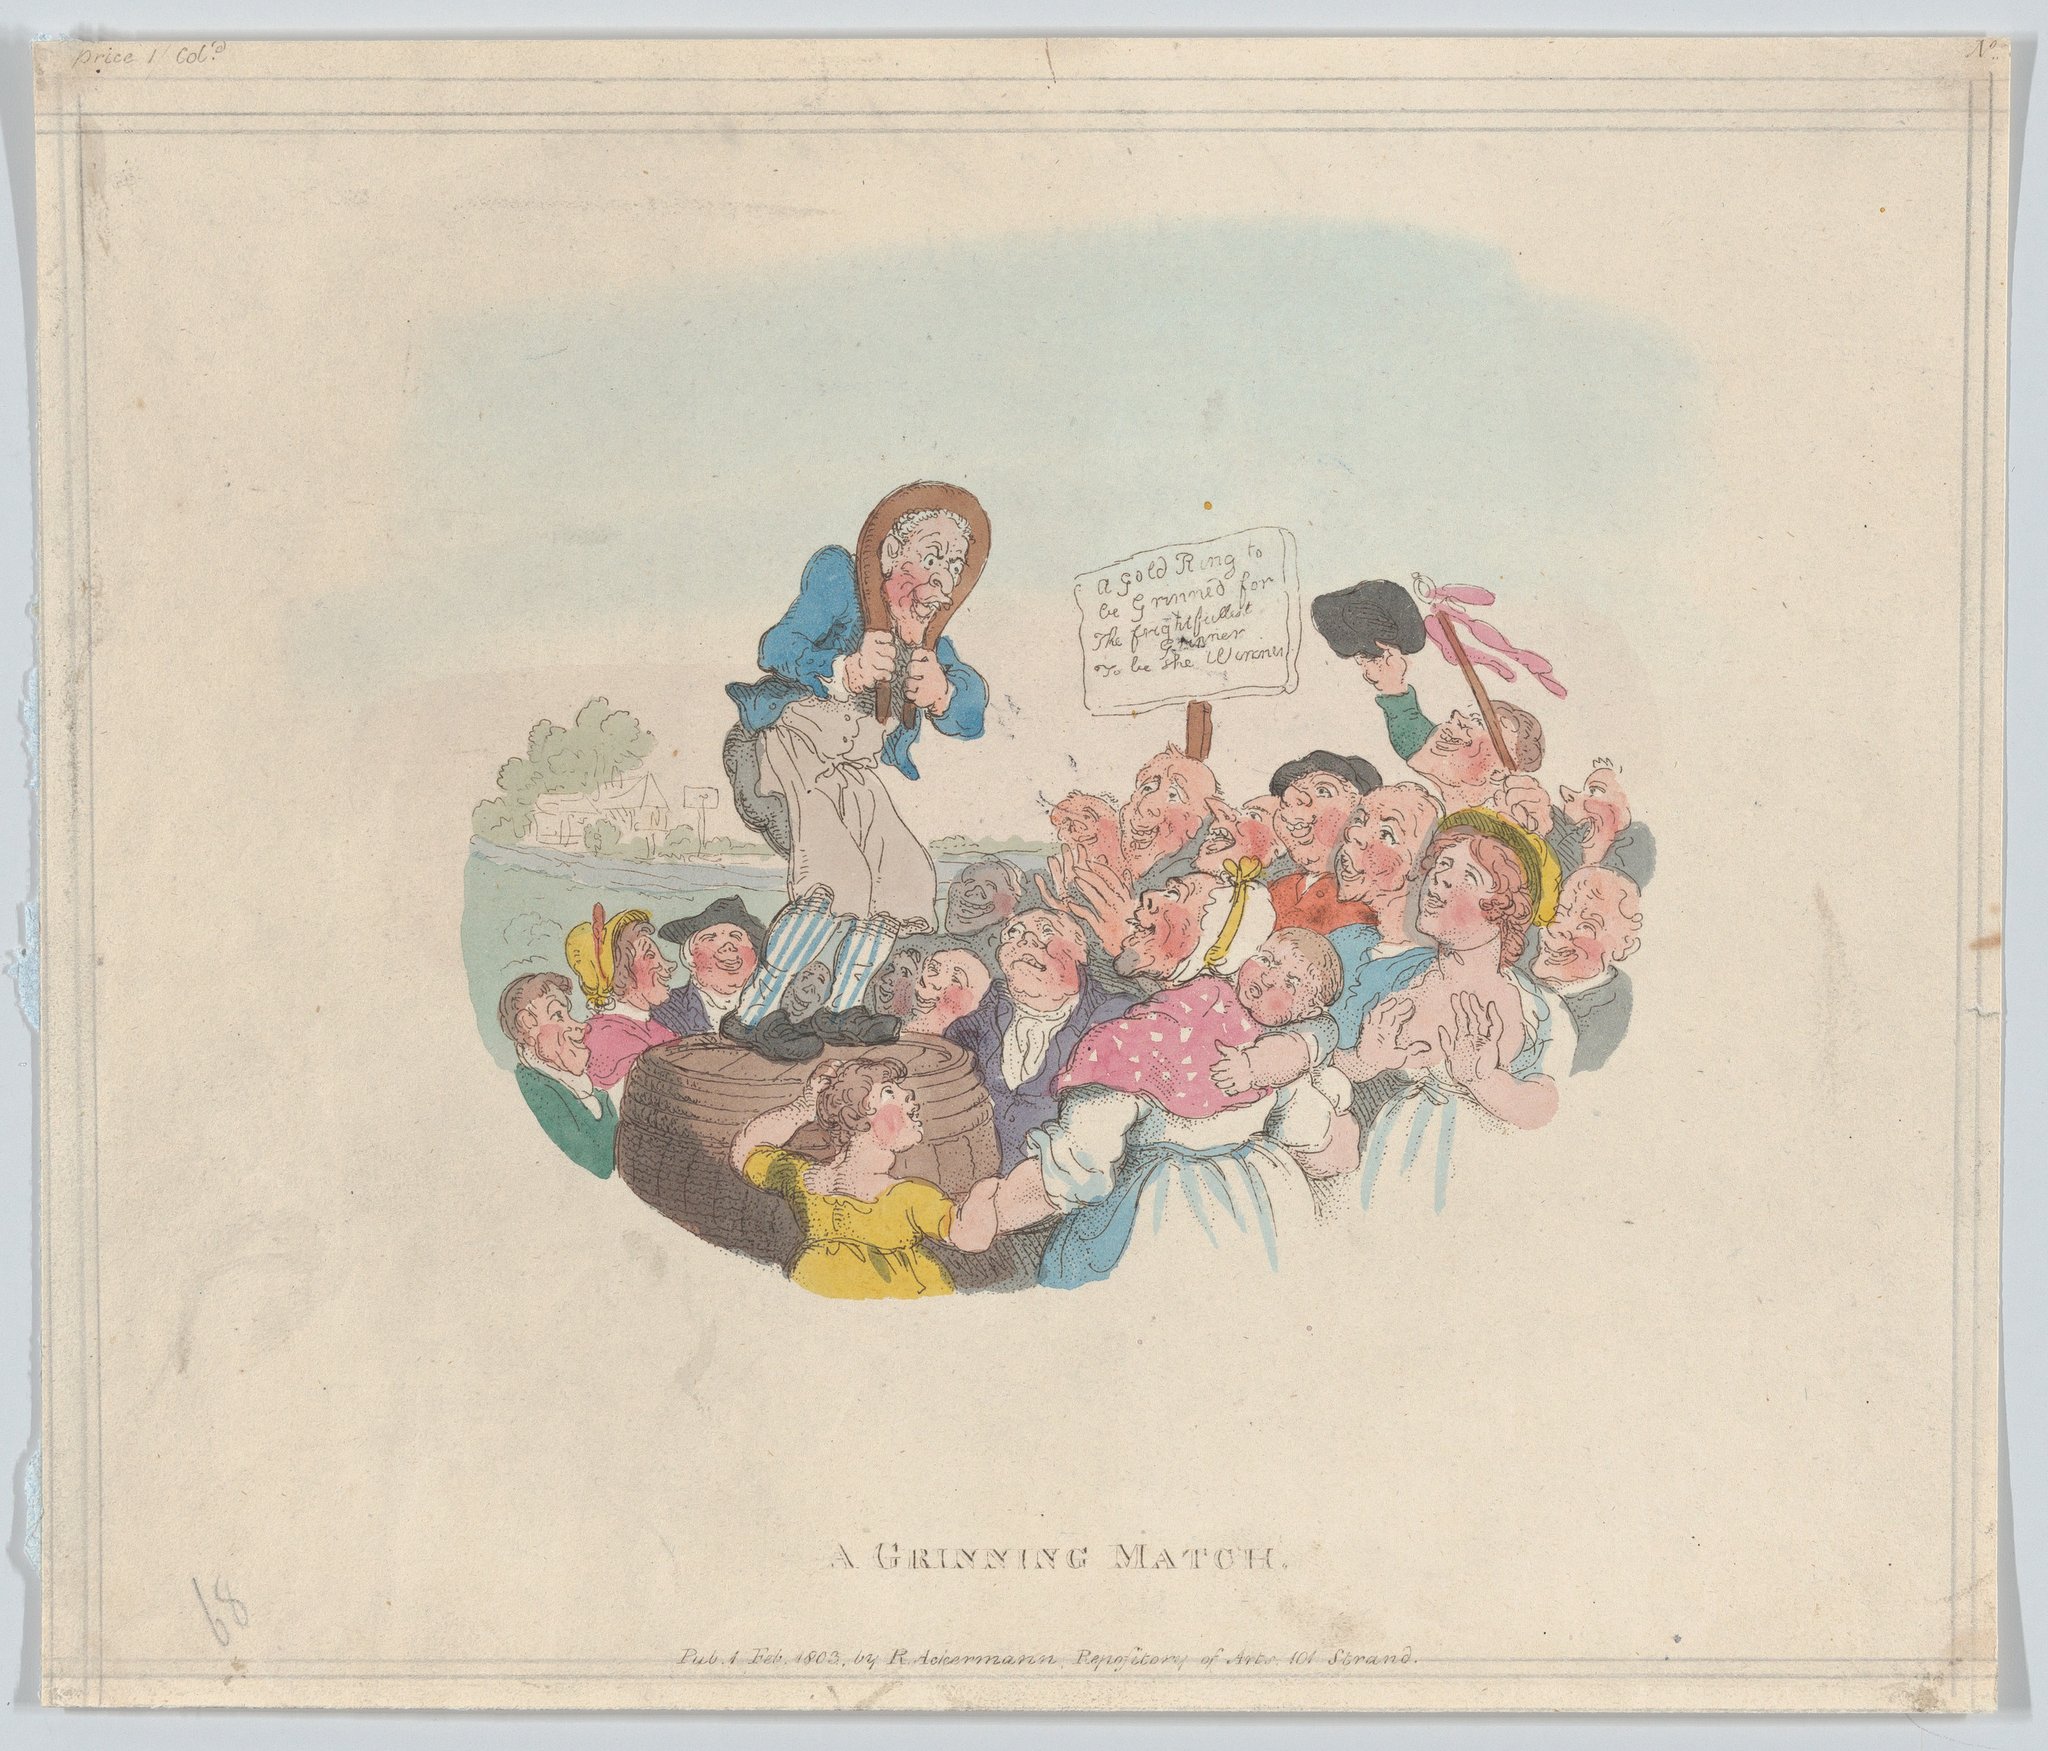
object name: print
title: A Grinning Match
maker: thomas rowlandson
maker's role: artist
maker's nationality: british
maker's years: 1757-1827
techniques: etching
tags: satire,men,women,spectators